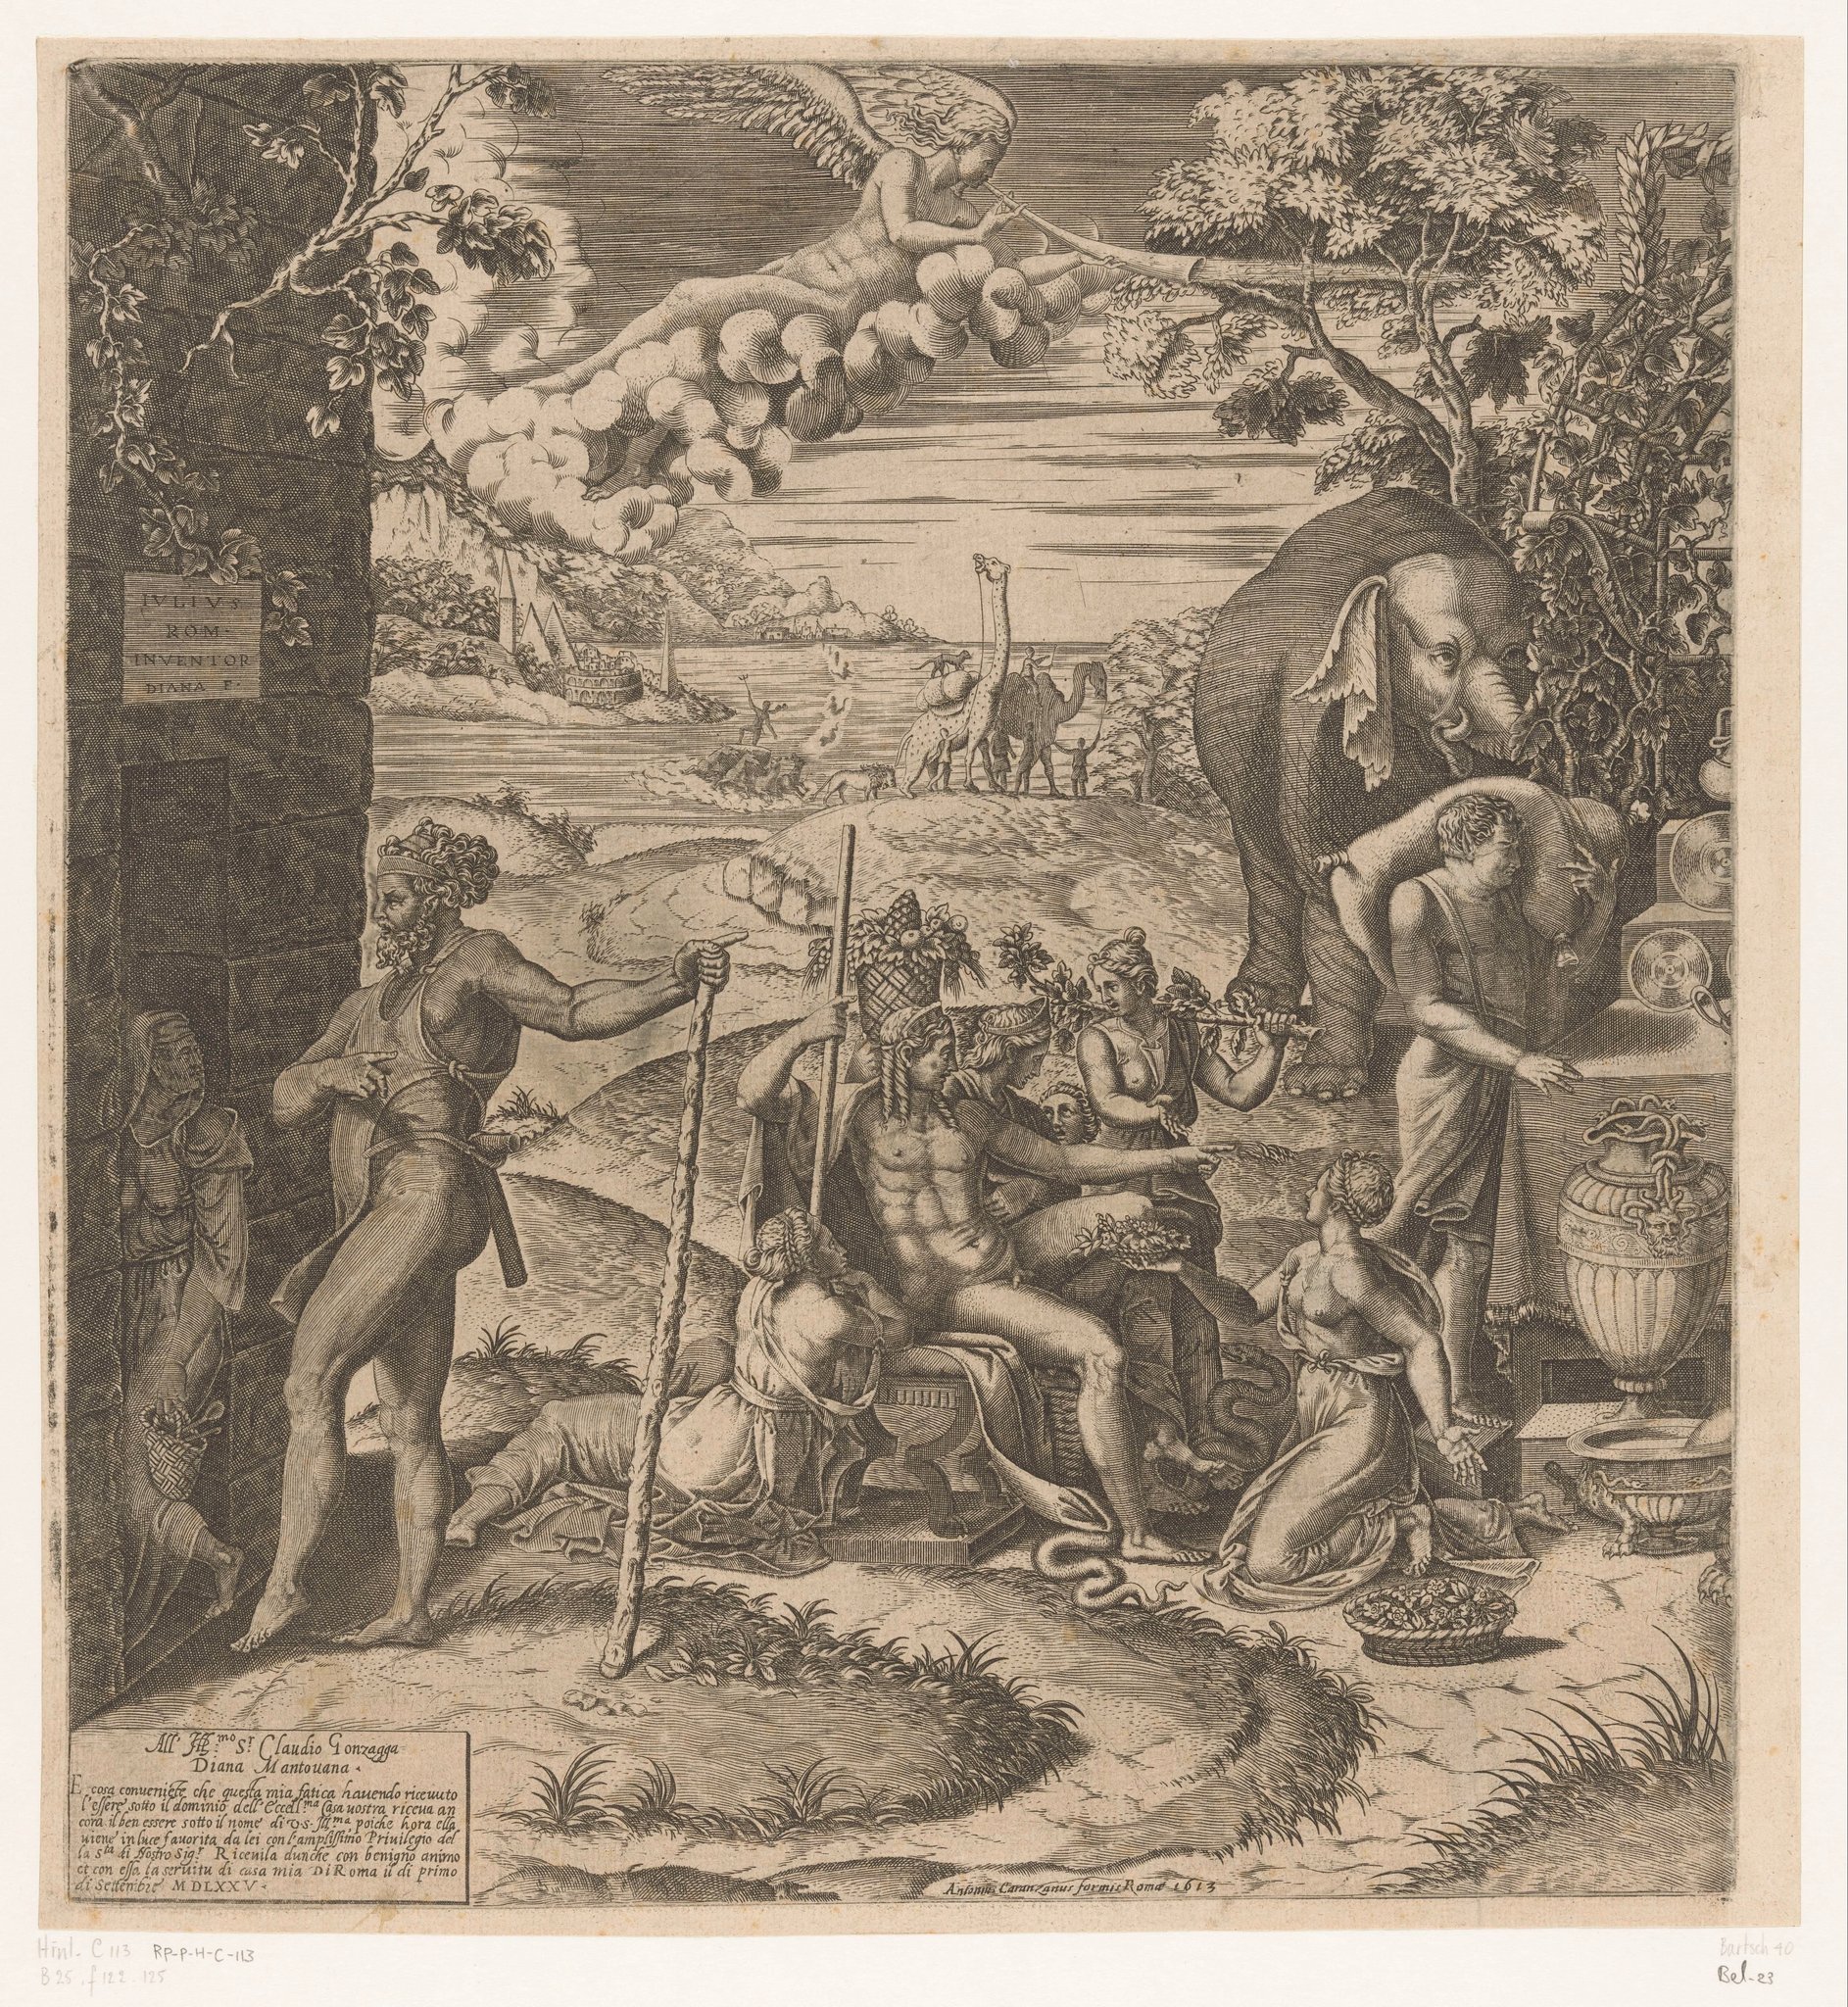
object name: print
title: Voorbereidingen voor het huwelijksfeest van Amor en Psyche (linkerdeel)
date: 1575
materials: paper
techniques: engraving, etching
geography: vatican city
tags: marriage of cupid and psyche, pomona, specific aspects, allegorical aspects of neptune; neptune as patron, (story of) flora, hoofed animals: giraffe, trunked animals: elephant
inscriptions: collector's mark: Lugt 10, collector's mark: Lugt 11, collector's mark: ‘Hinloopen’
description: Apollo zittend en omringd door godinnen waaronder Flora en Pomona. Op de achtergrond een landschap met piramides, een amfitheater, Neptunus met zijn drietand en een gezelschap met exotische dieren. Rechts een olifant en een man met een zak over zijn schouder.